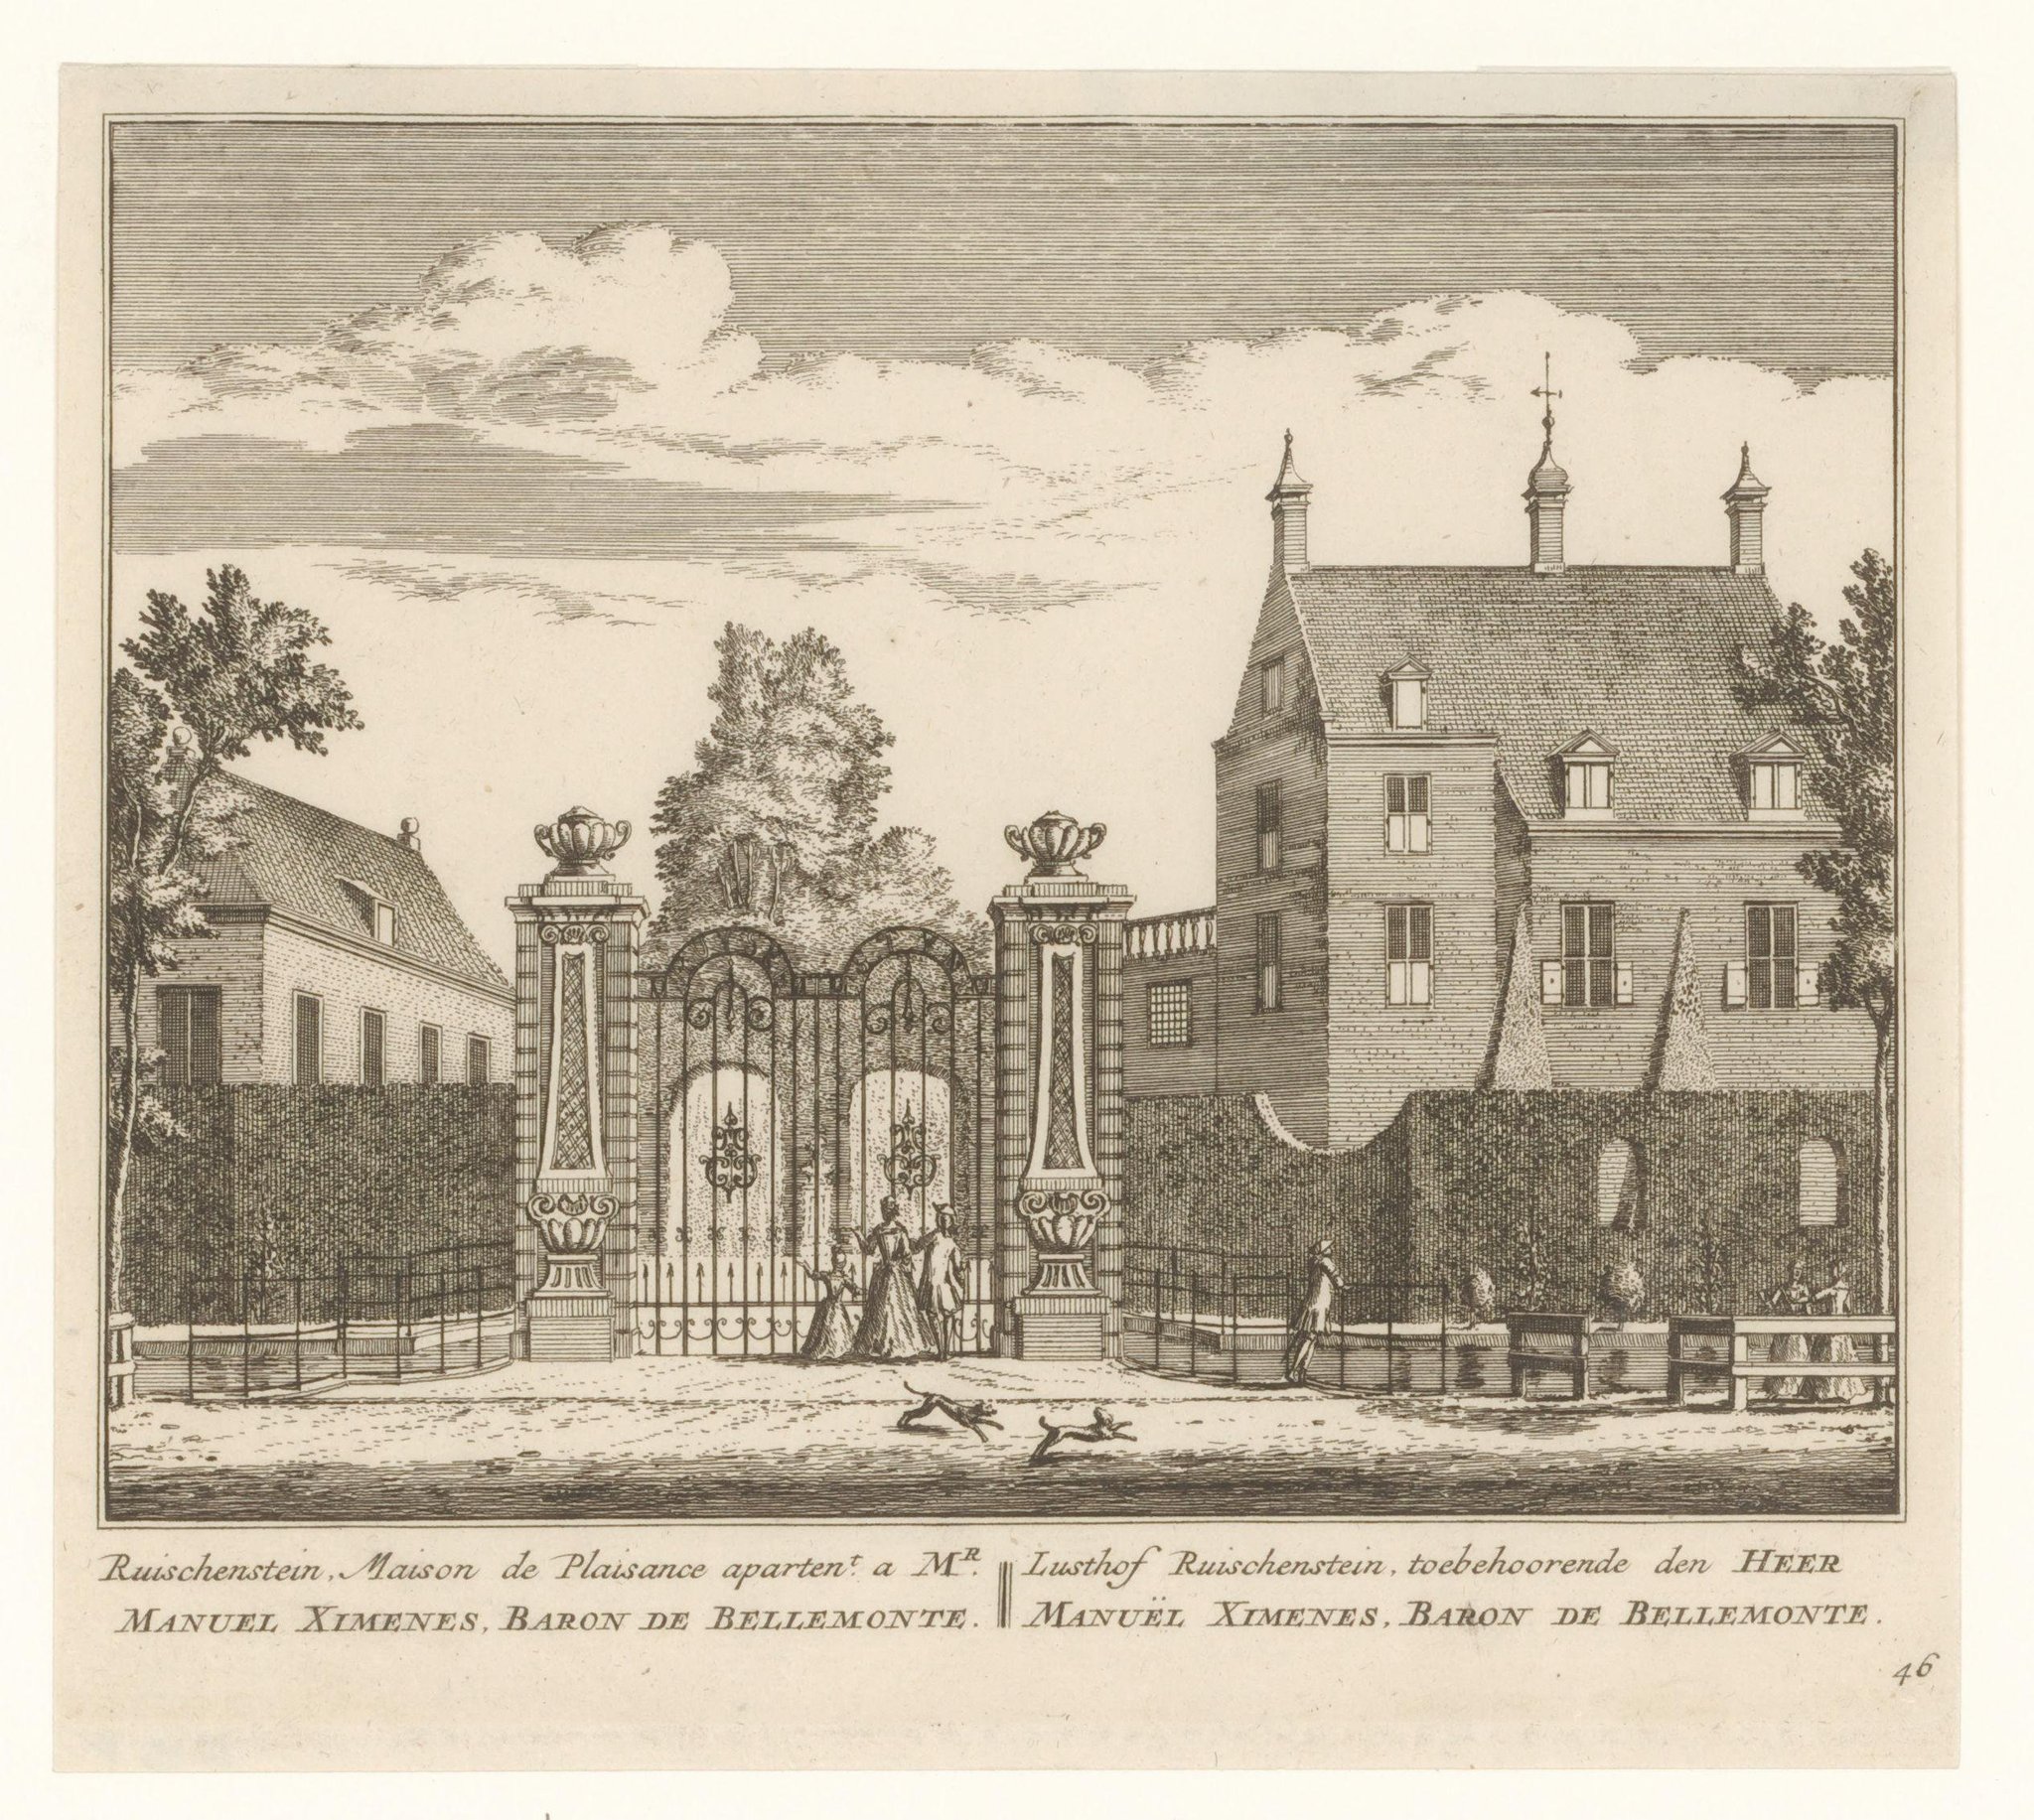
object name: print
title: Lusthof Ruischenstein, toebehoorende den Heer Manuël Ximenes, Baron de Bellemonte / Ruischenstein, Maison de Plaisance apartent a Mr. Manuel Ximenes, Baron de Bellemonte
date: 1730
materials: paper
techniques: etching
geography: amsterdam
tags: city-view in general; 'veduta', river, rural housing, e.g. country-house, villa, cottage, gate, entrance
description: Prent waarschijnlijk uit: Tijsens, Gijsbert. Hollands Arcadia, of de vermaarde rivier den Amstel (...) naar 't léven getekend en in 't ligt gebragt door Abraham Rademaker (...). Amsterdam: Leonardus Schenk, 1730.